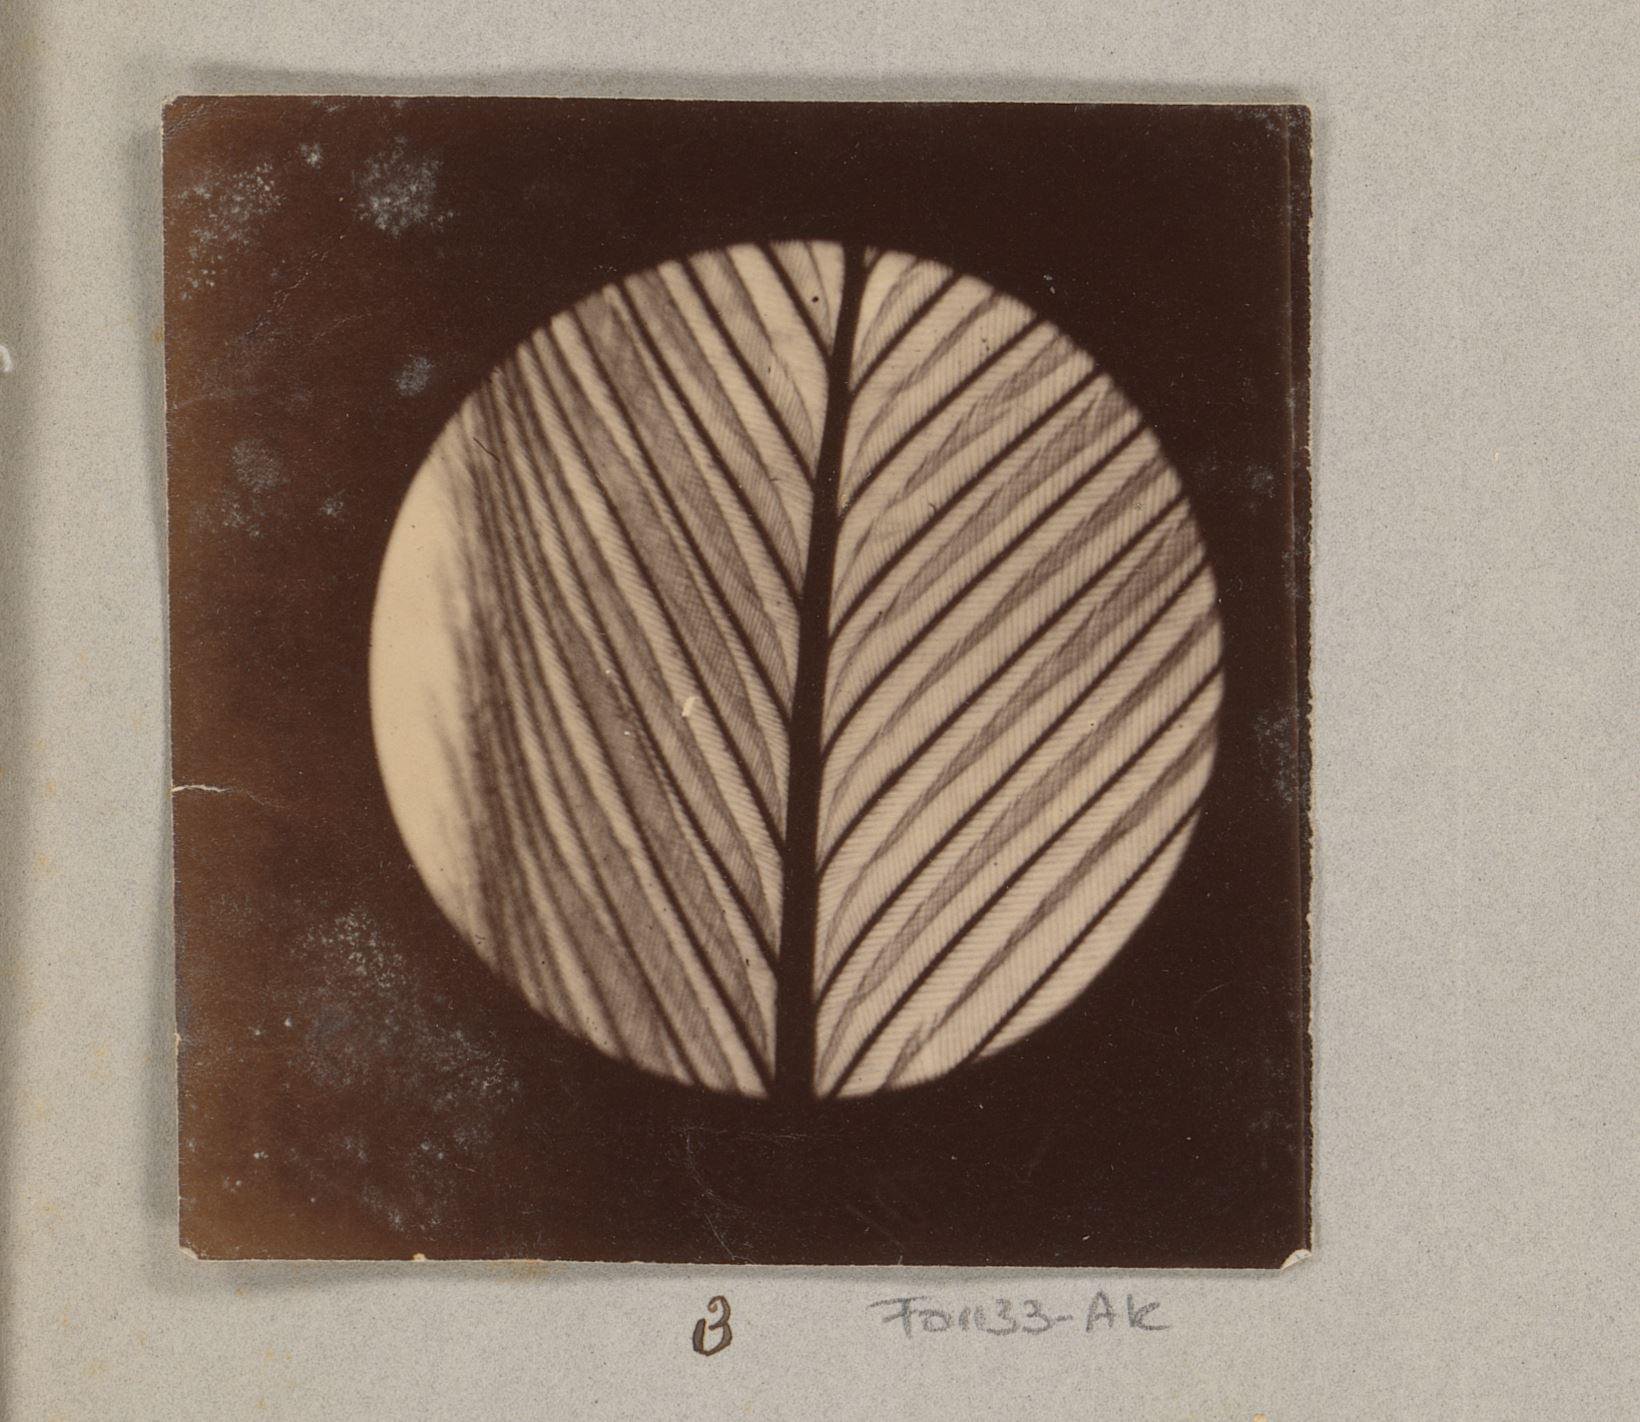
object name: photograph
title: Microscopische opname van veer van een kolibrie, 25 keer vergroot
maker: marinus pieter filbri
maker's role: instrument maker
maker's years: 1852-1917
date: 1887-1888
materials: paper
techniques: albumen print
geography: netherlands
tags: birds, netherlands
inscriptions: inscription: ‘No. 3. Benaming Veertje van een kolibri, vergroot 25 x, pose 3 min., bemerking id.’